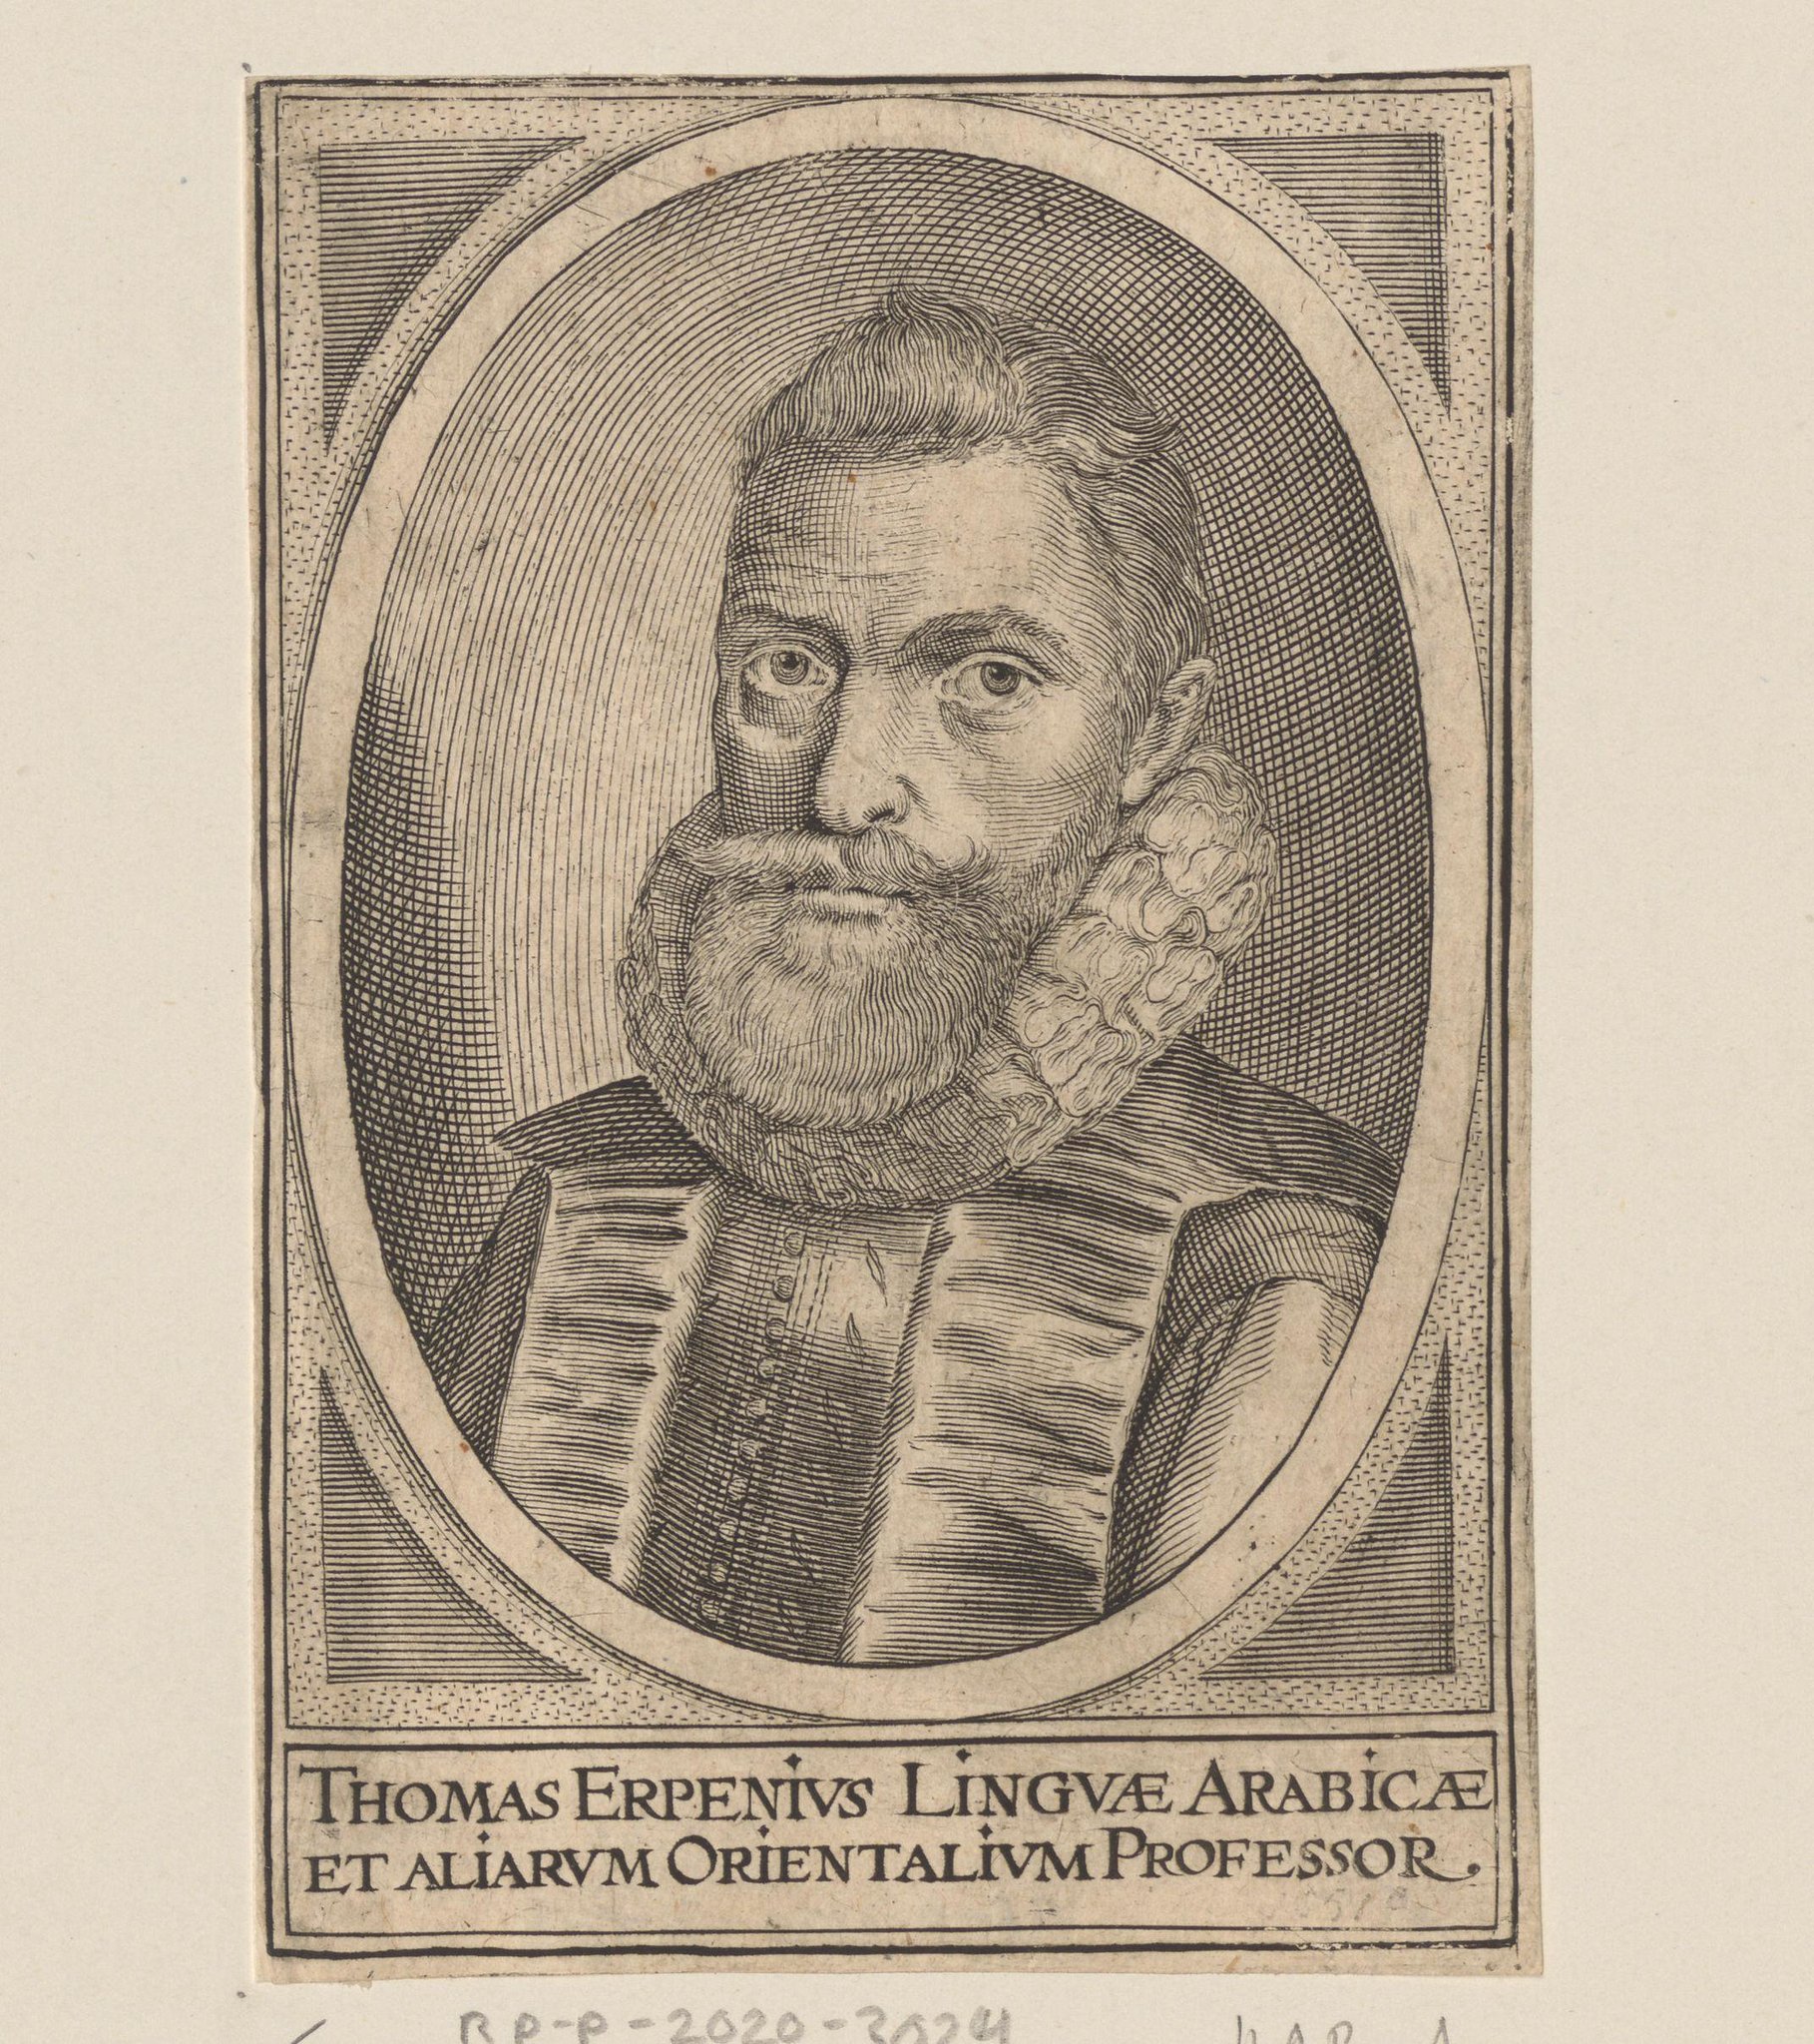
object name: book illustration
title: Portret van Thomas Erpenius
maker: Anonymous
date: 1614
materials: paper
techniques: engraving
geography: germany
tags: historical persons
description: Prent waarschijnlijk uit: Meursius, Joannes. Illustrium Hollandiae & Westfrisiae ordinum alma academia Leidensis. Leiden: Jacob Marcus en Joost van Colster, 1614.